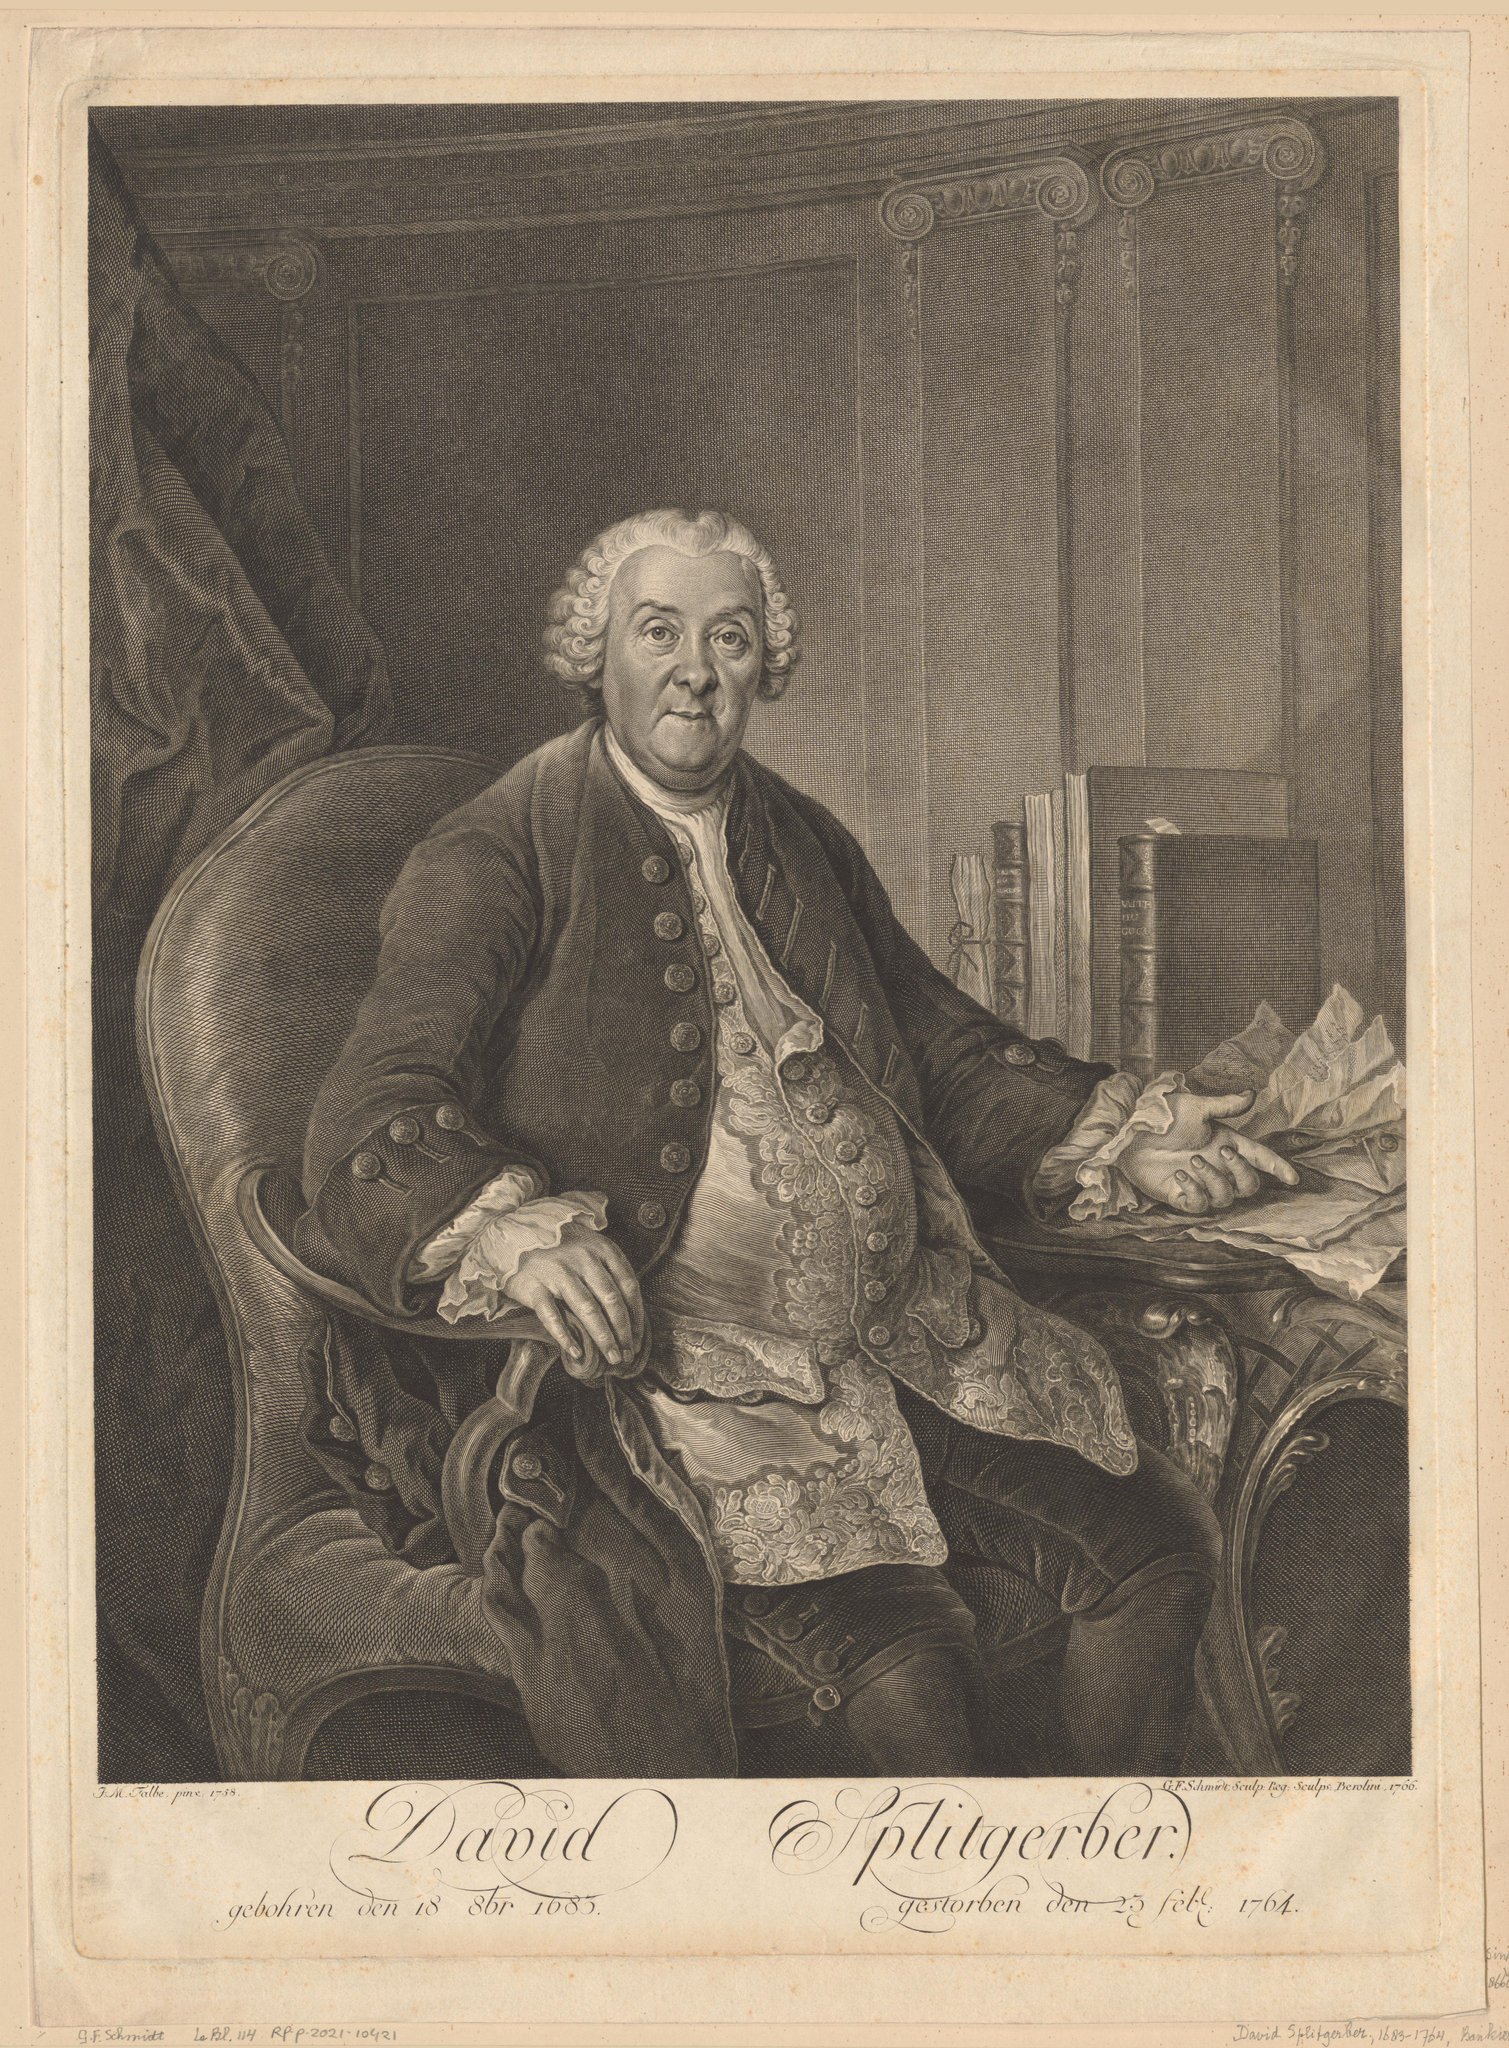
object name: print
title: Portret van David Splitgerber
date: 1766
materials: paper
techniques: engraving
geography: berlin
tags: berlin, manufacturer, adult man, historical persons, book, letter, envelope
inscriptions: date